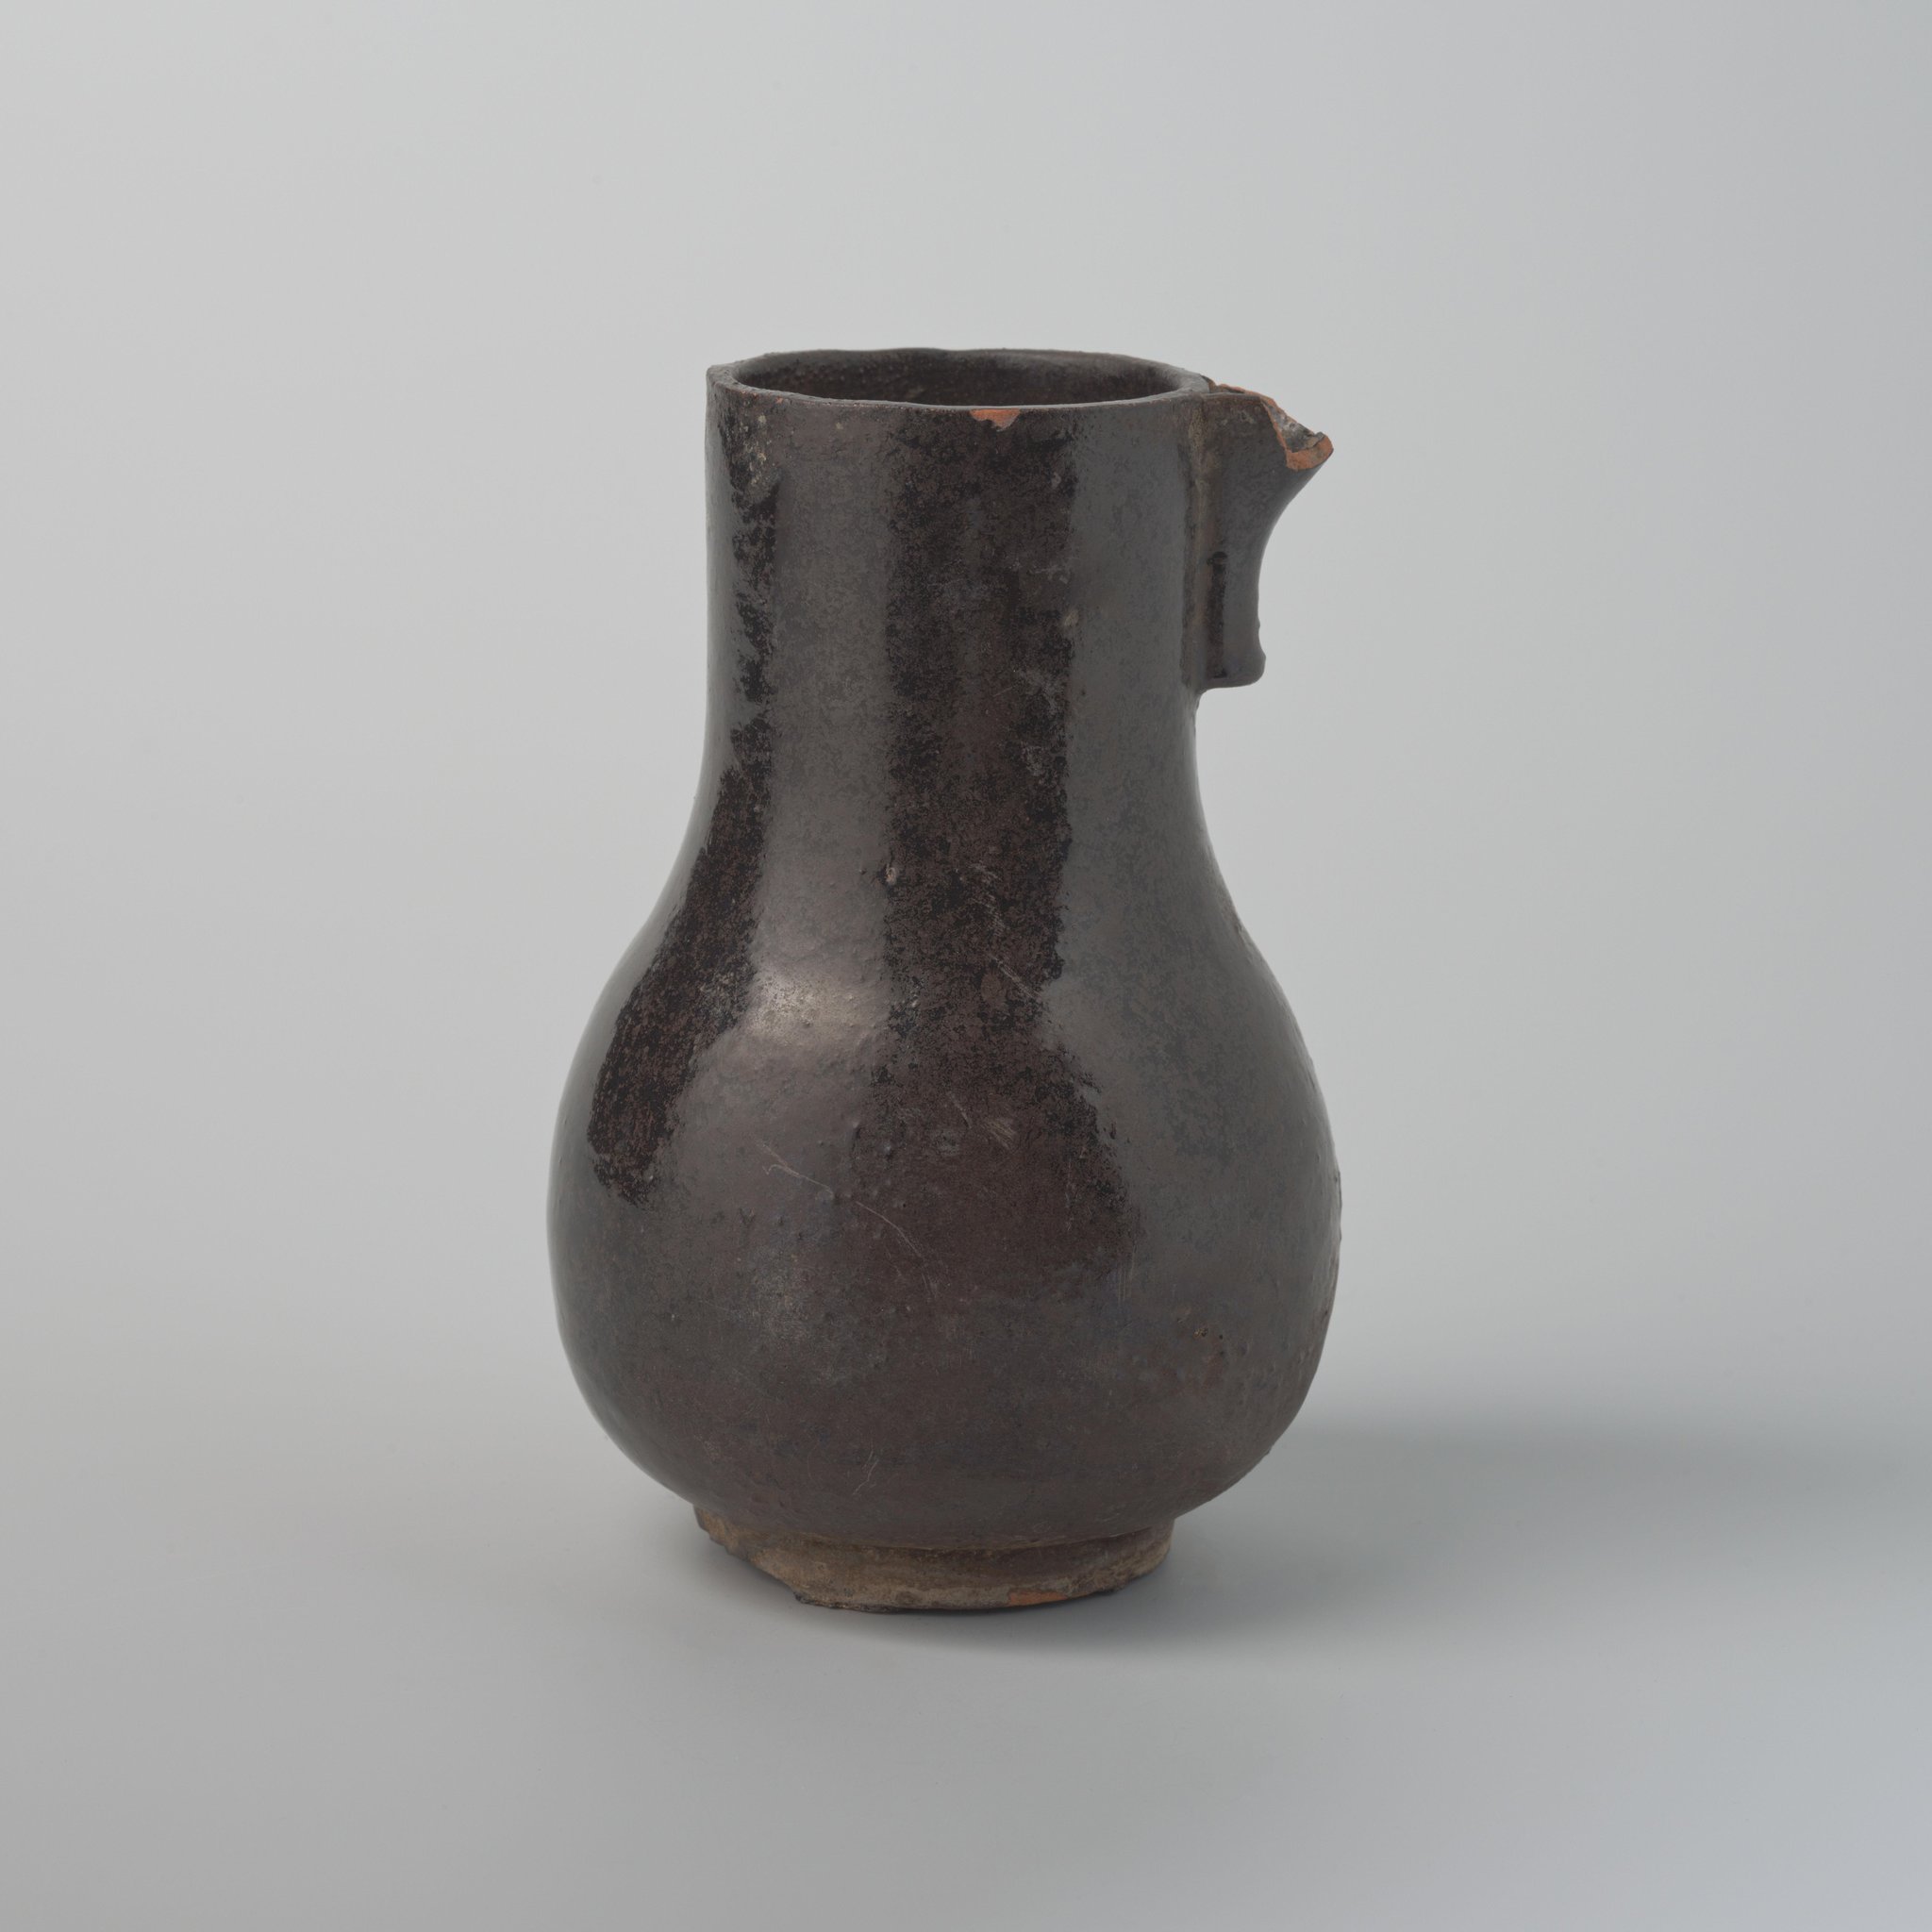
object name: bakafval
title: Kan met een zwart glazuur (De Caluwe bakafval)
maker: jacobus de caluwe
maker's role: plateelbakkerij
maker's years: -1730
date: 1700-1725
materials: earthenware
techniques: firing, vitrification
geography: delft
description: Toegeschreven aan Jacobus de Caluwe, omdat dit voorwerp samen met gemerkte stukken (‘Jacobus De Caluwe’ en rennend hert) gevonden is op de plaats waar zich De Caluwes tweede werkplaats bevond. Er is een duidelijke stilistische overeenkomst tussen de gemerkte en niet gemerkte voorwerpen uit deze archeologische vondst.